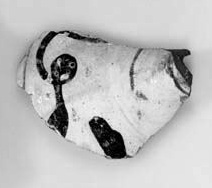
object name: shard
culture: korean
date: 1401-1500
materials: pottery